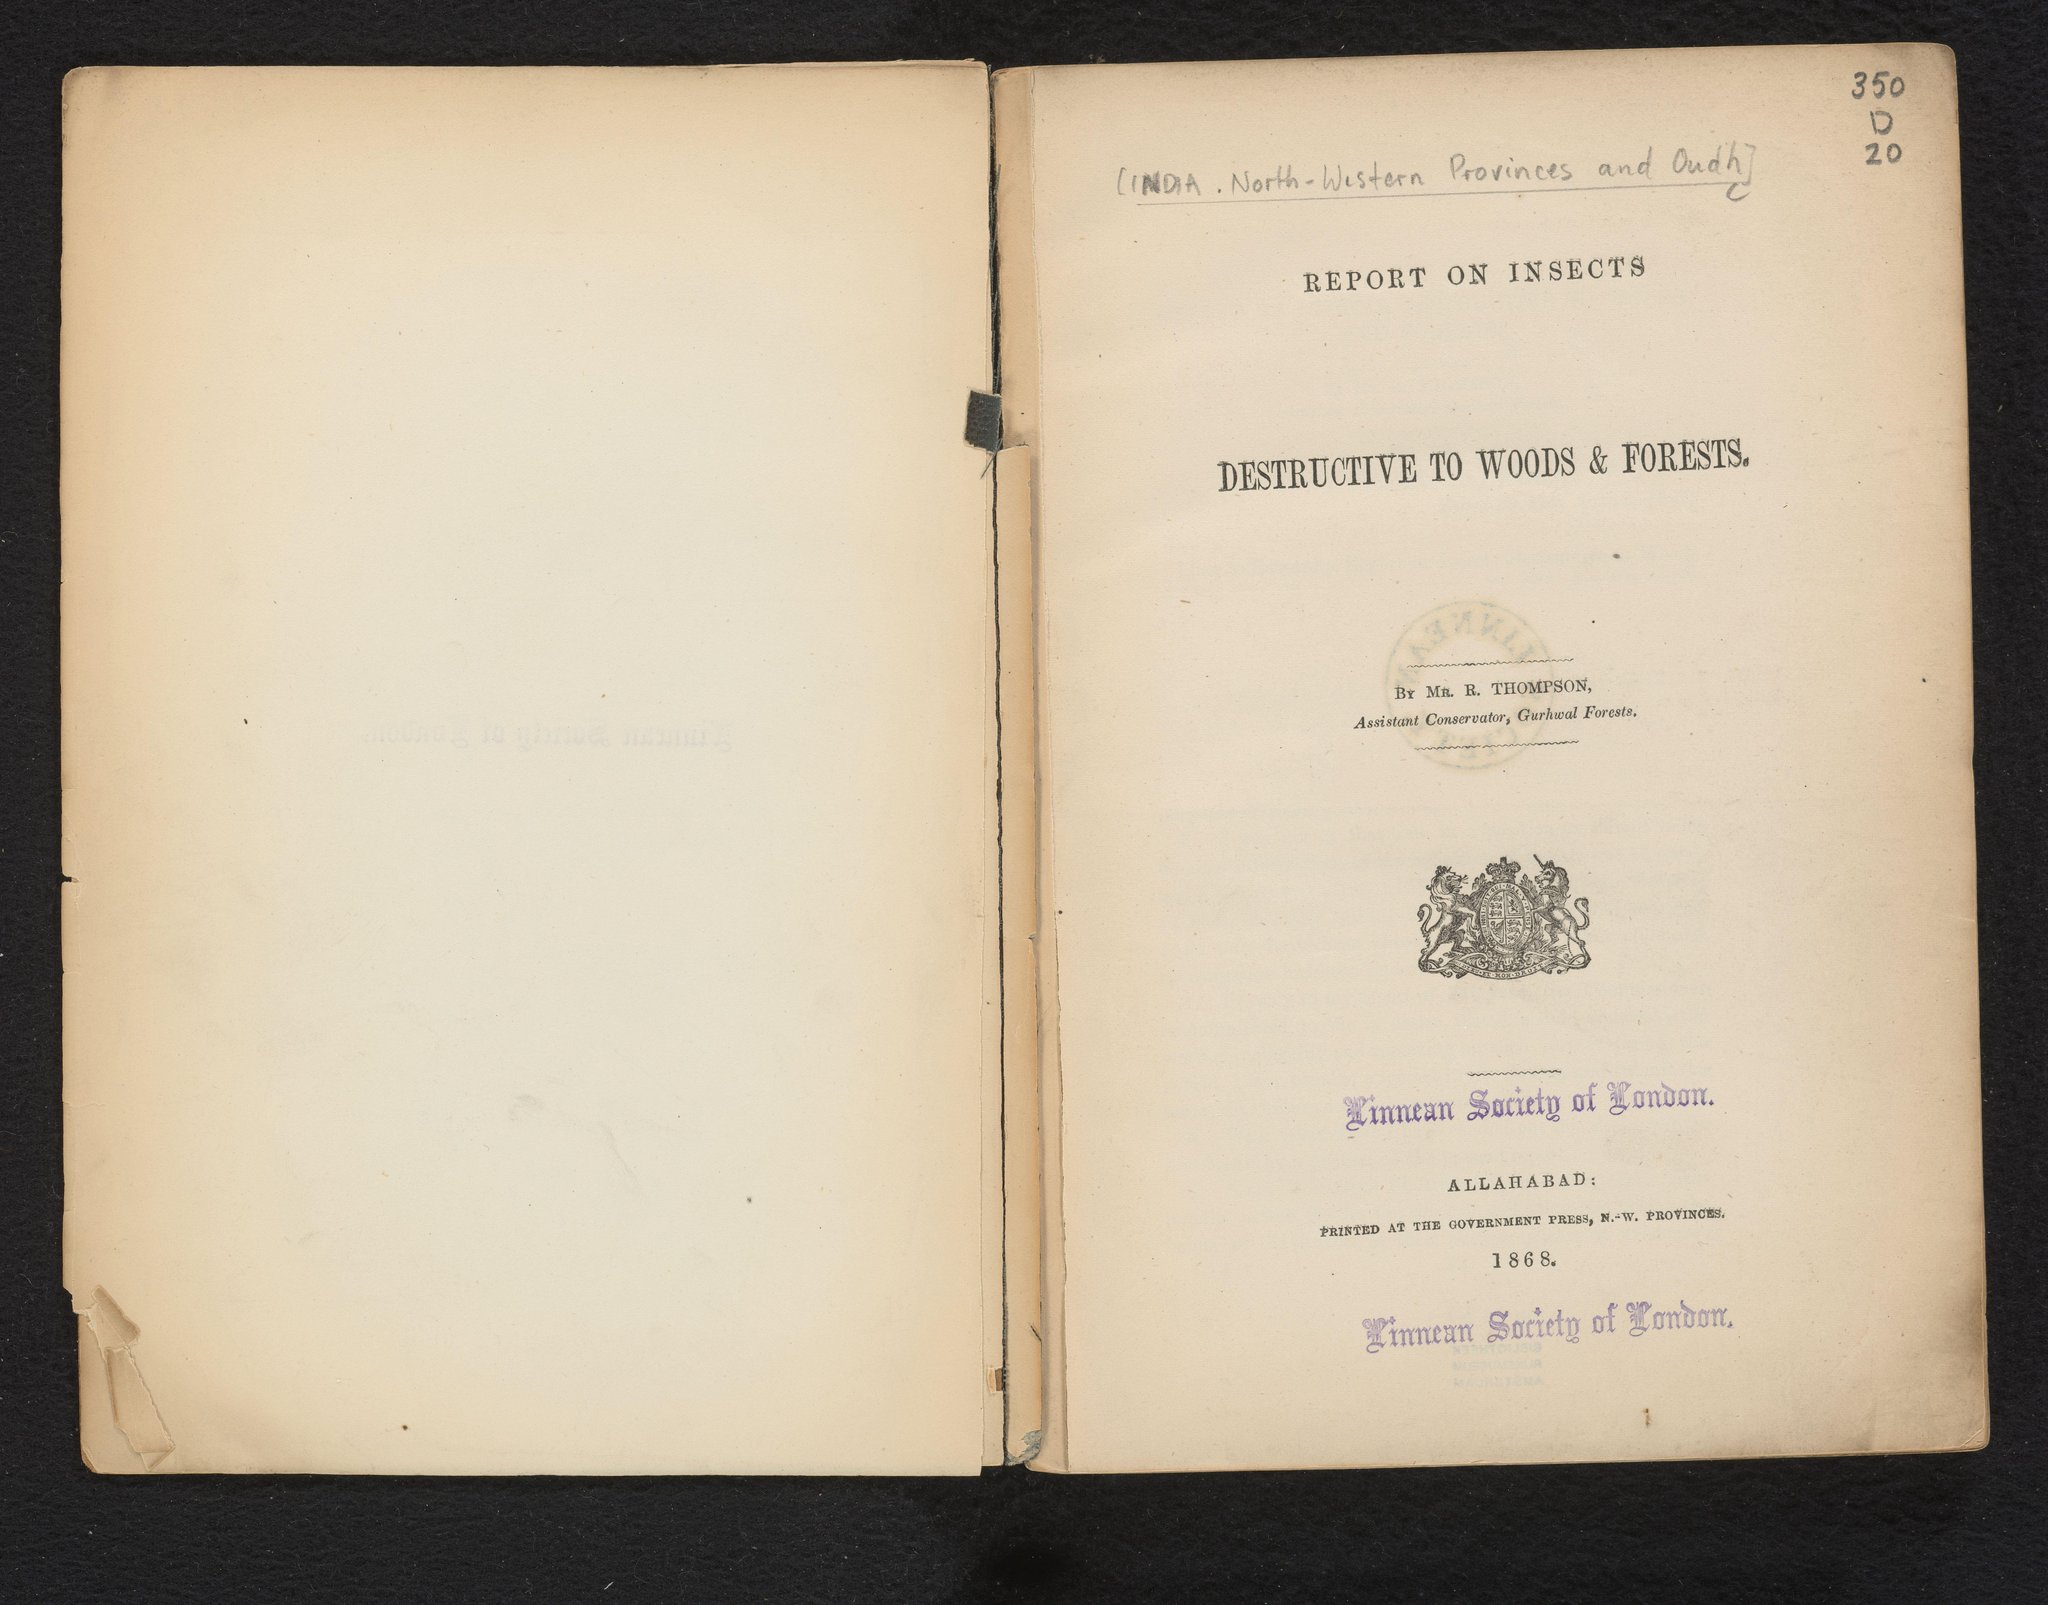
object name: book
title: Report on insects destructive to woods and forests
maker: r. thompson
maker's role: publisher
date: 1868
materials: cardboard, paper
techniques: albumen print, printing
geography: allahabad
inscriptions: inscription: ‘Linnean Society of London.’